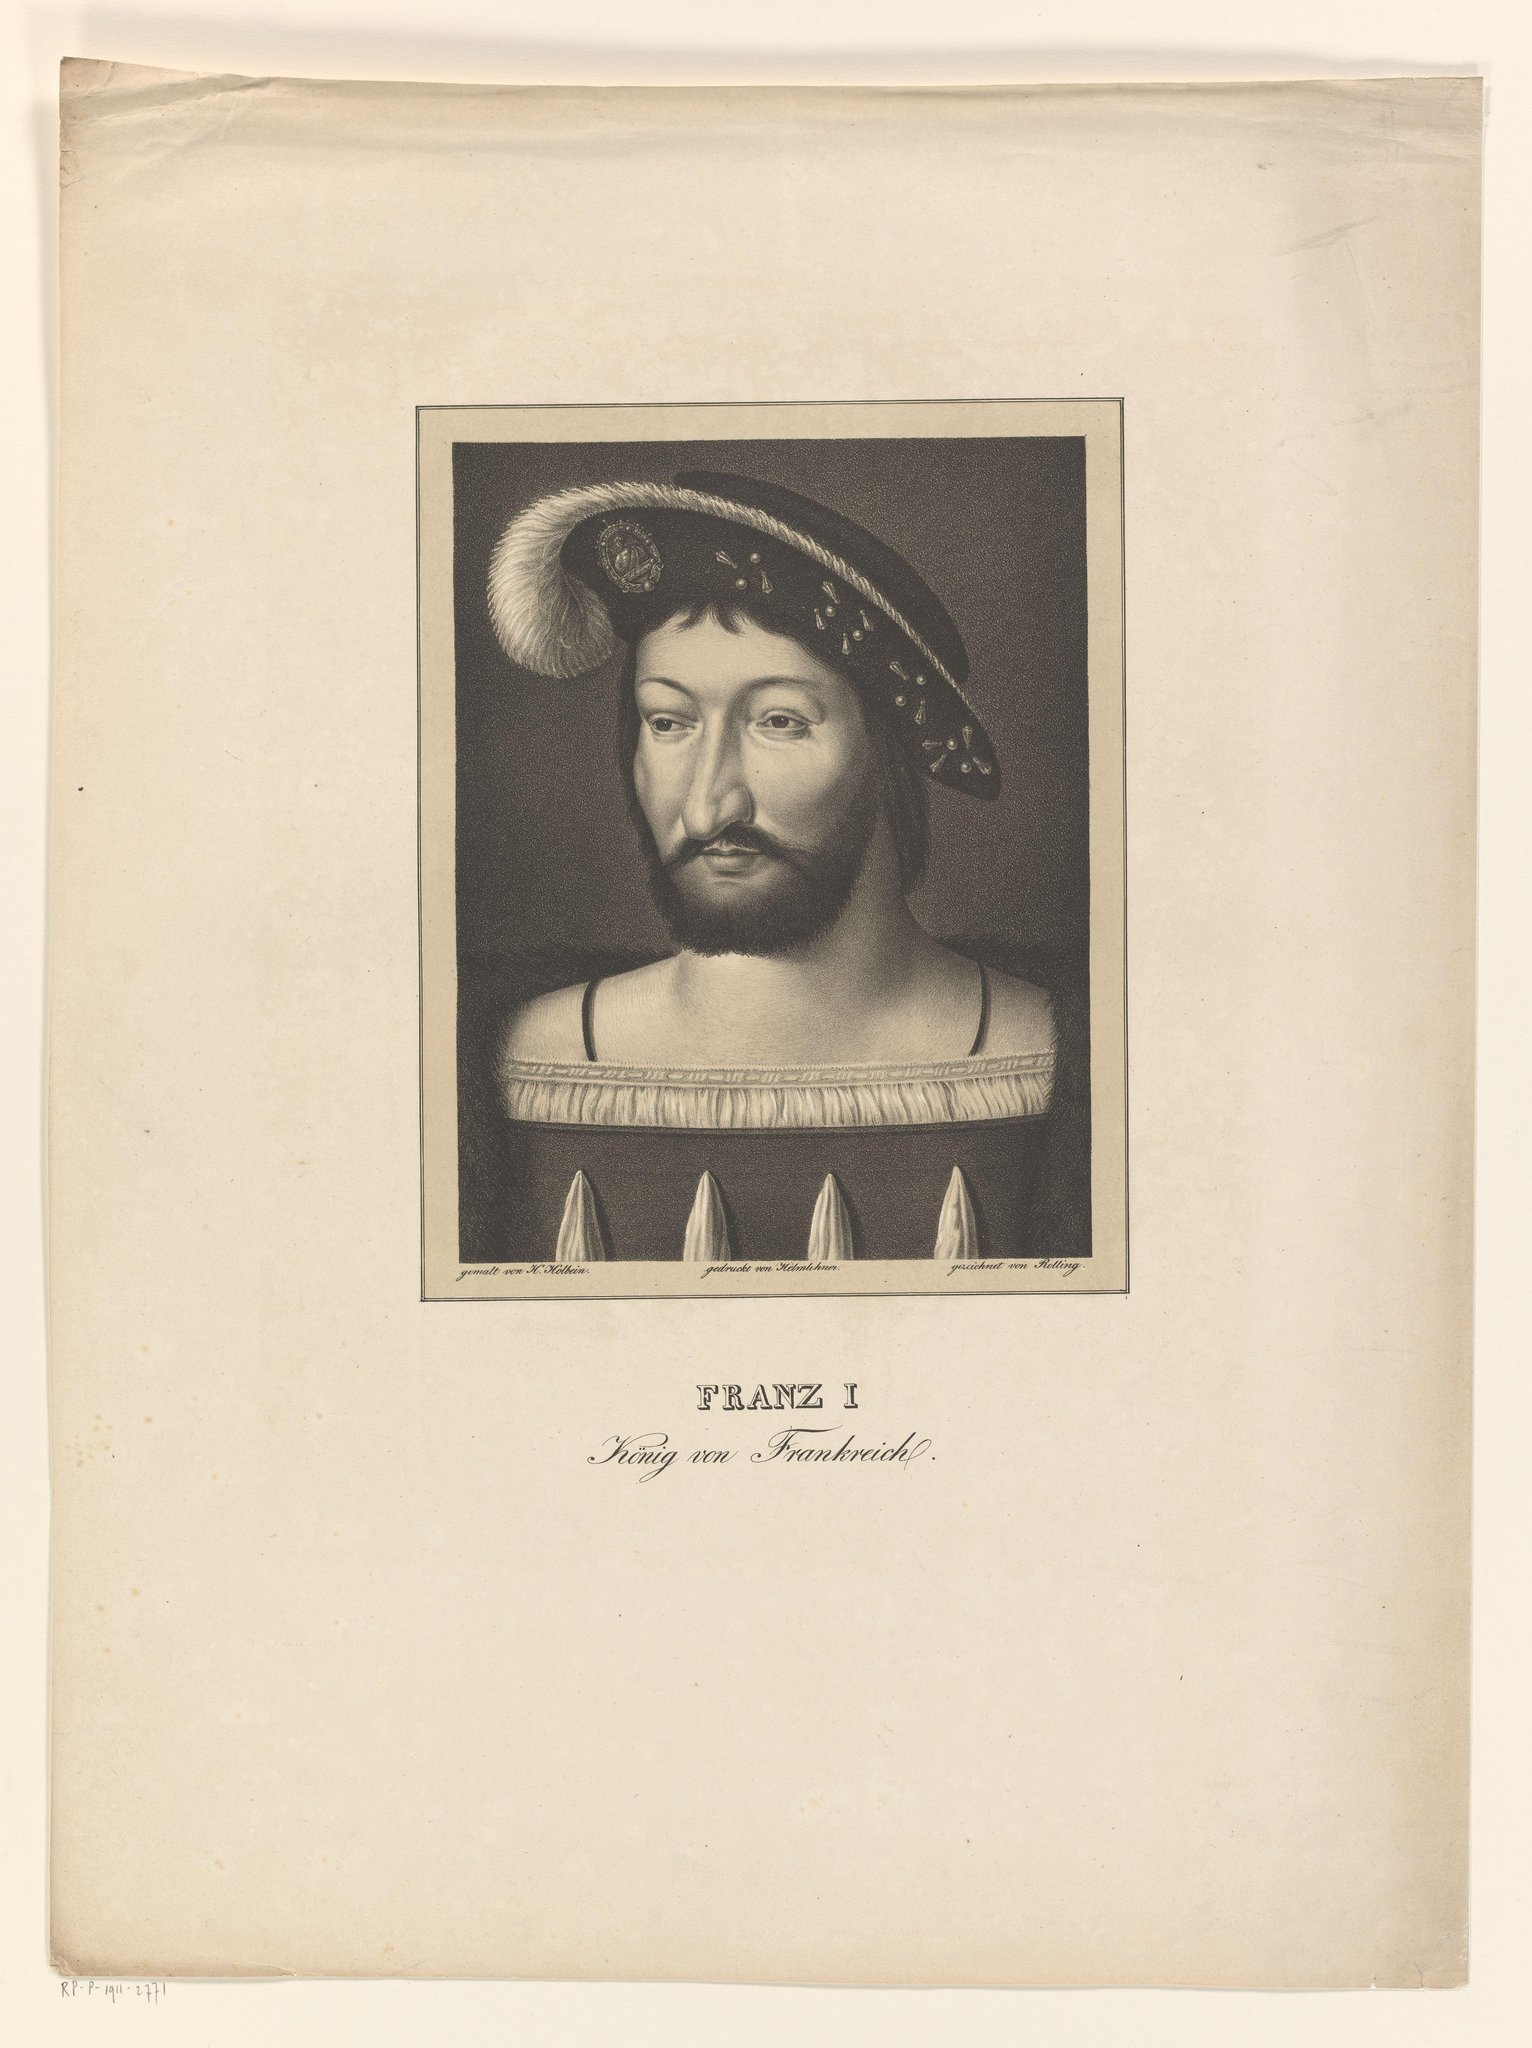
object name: print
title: Portret van Frans I, koning van Frankrijk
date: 1820-1860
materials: paper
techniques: tone lithography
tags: frans i van valois-angoulême (koning van frankrijk), head-gear, adult man, historical persons, beard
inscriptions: check stamp: ‘[k]arrig’, collector's mark: Lugt 2228